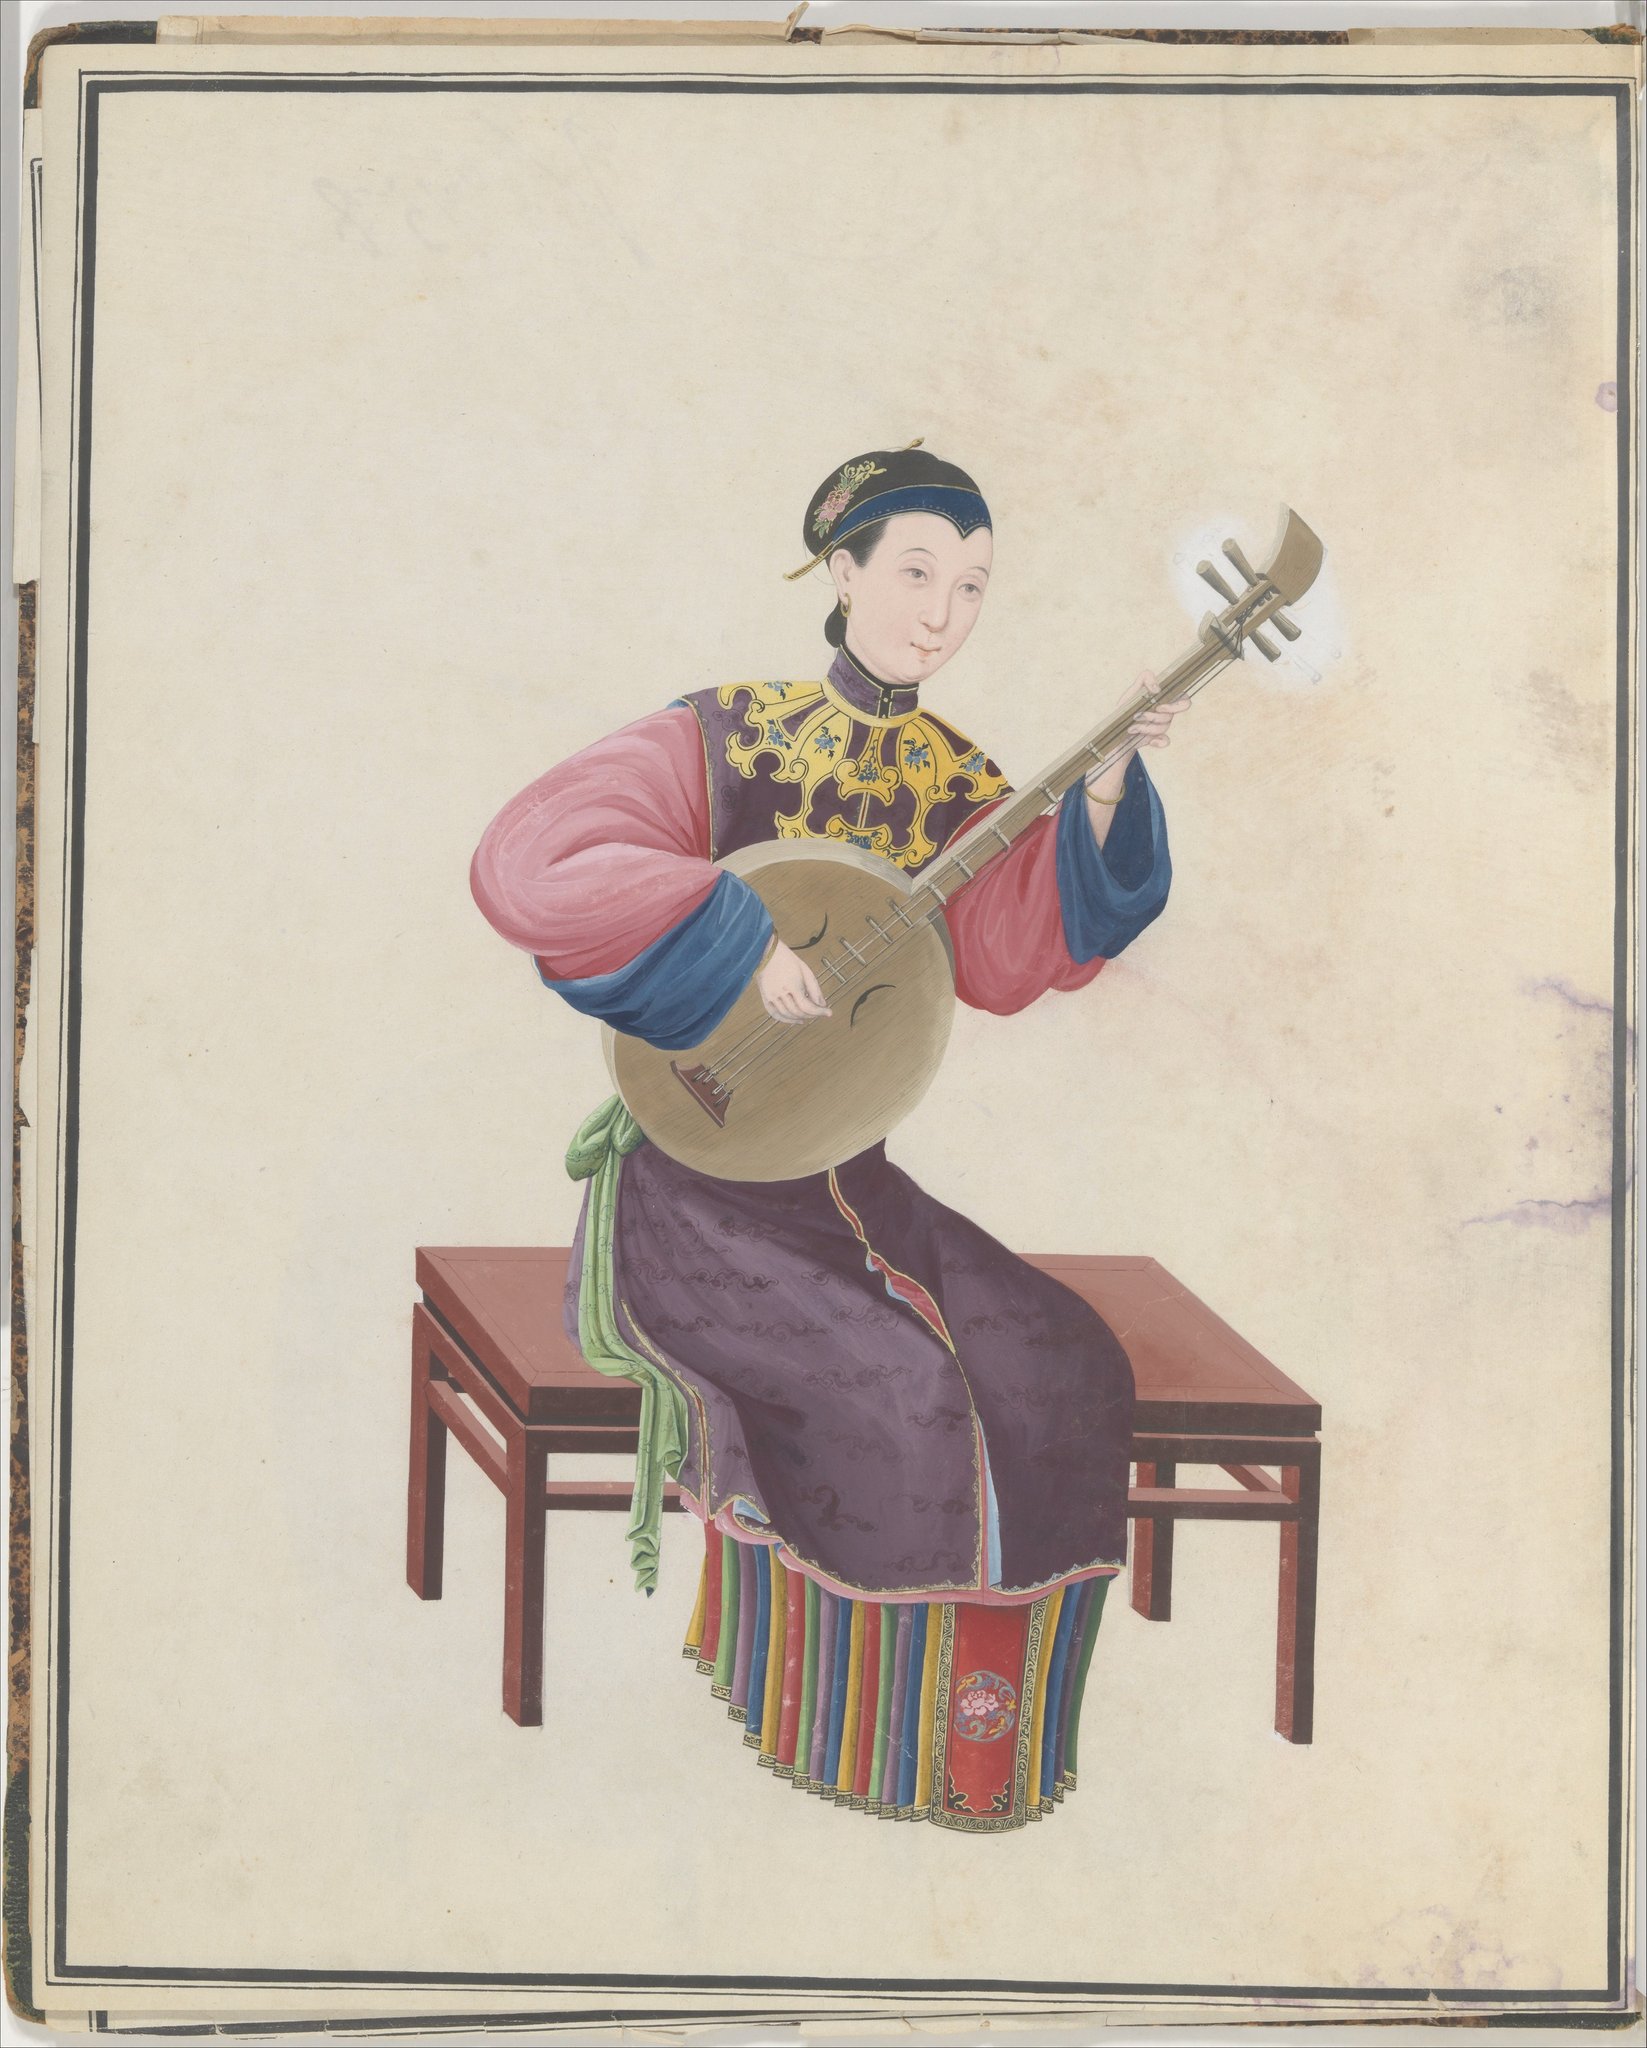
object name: watercolor of musician playing ruan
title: Watercolor of musician playing ruan(?)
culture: chinese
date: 1767-1800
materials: paper, watercolor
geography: china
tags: musical instruments,women,musicians